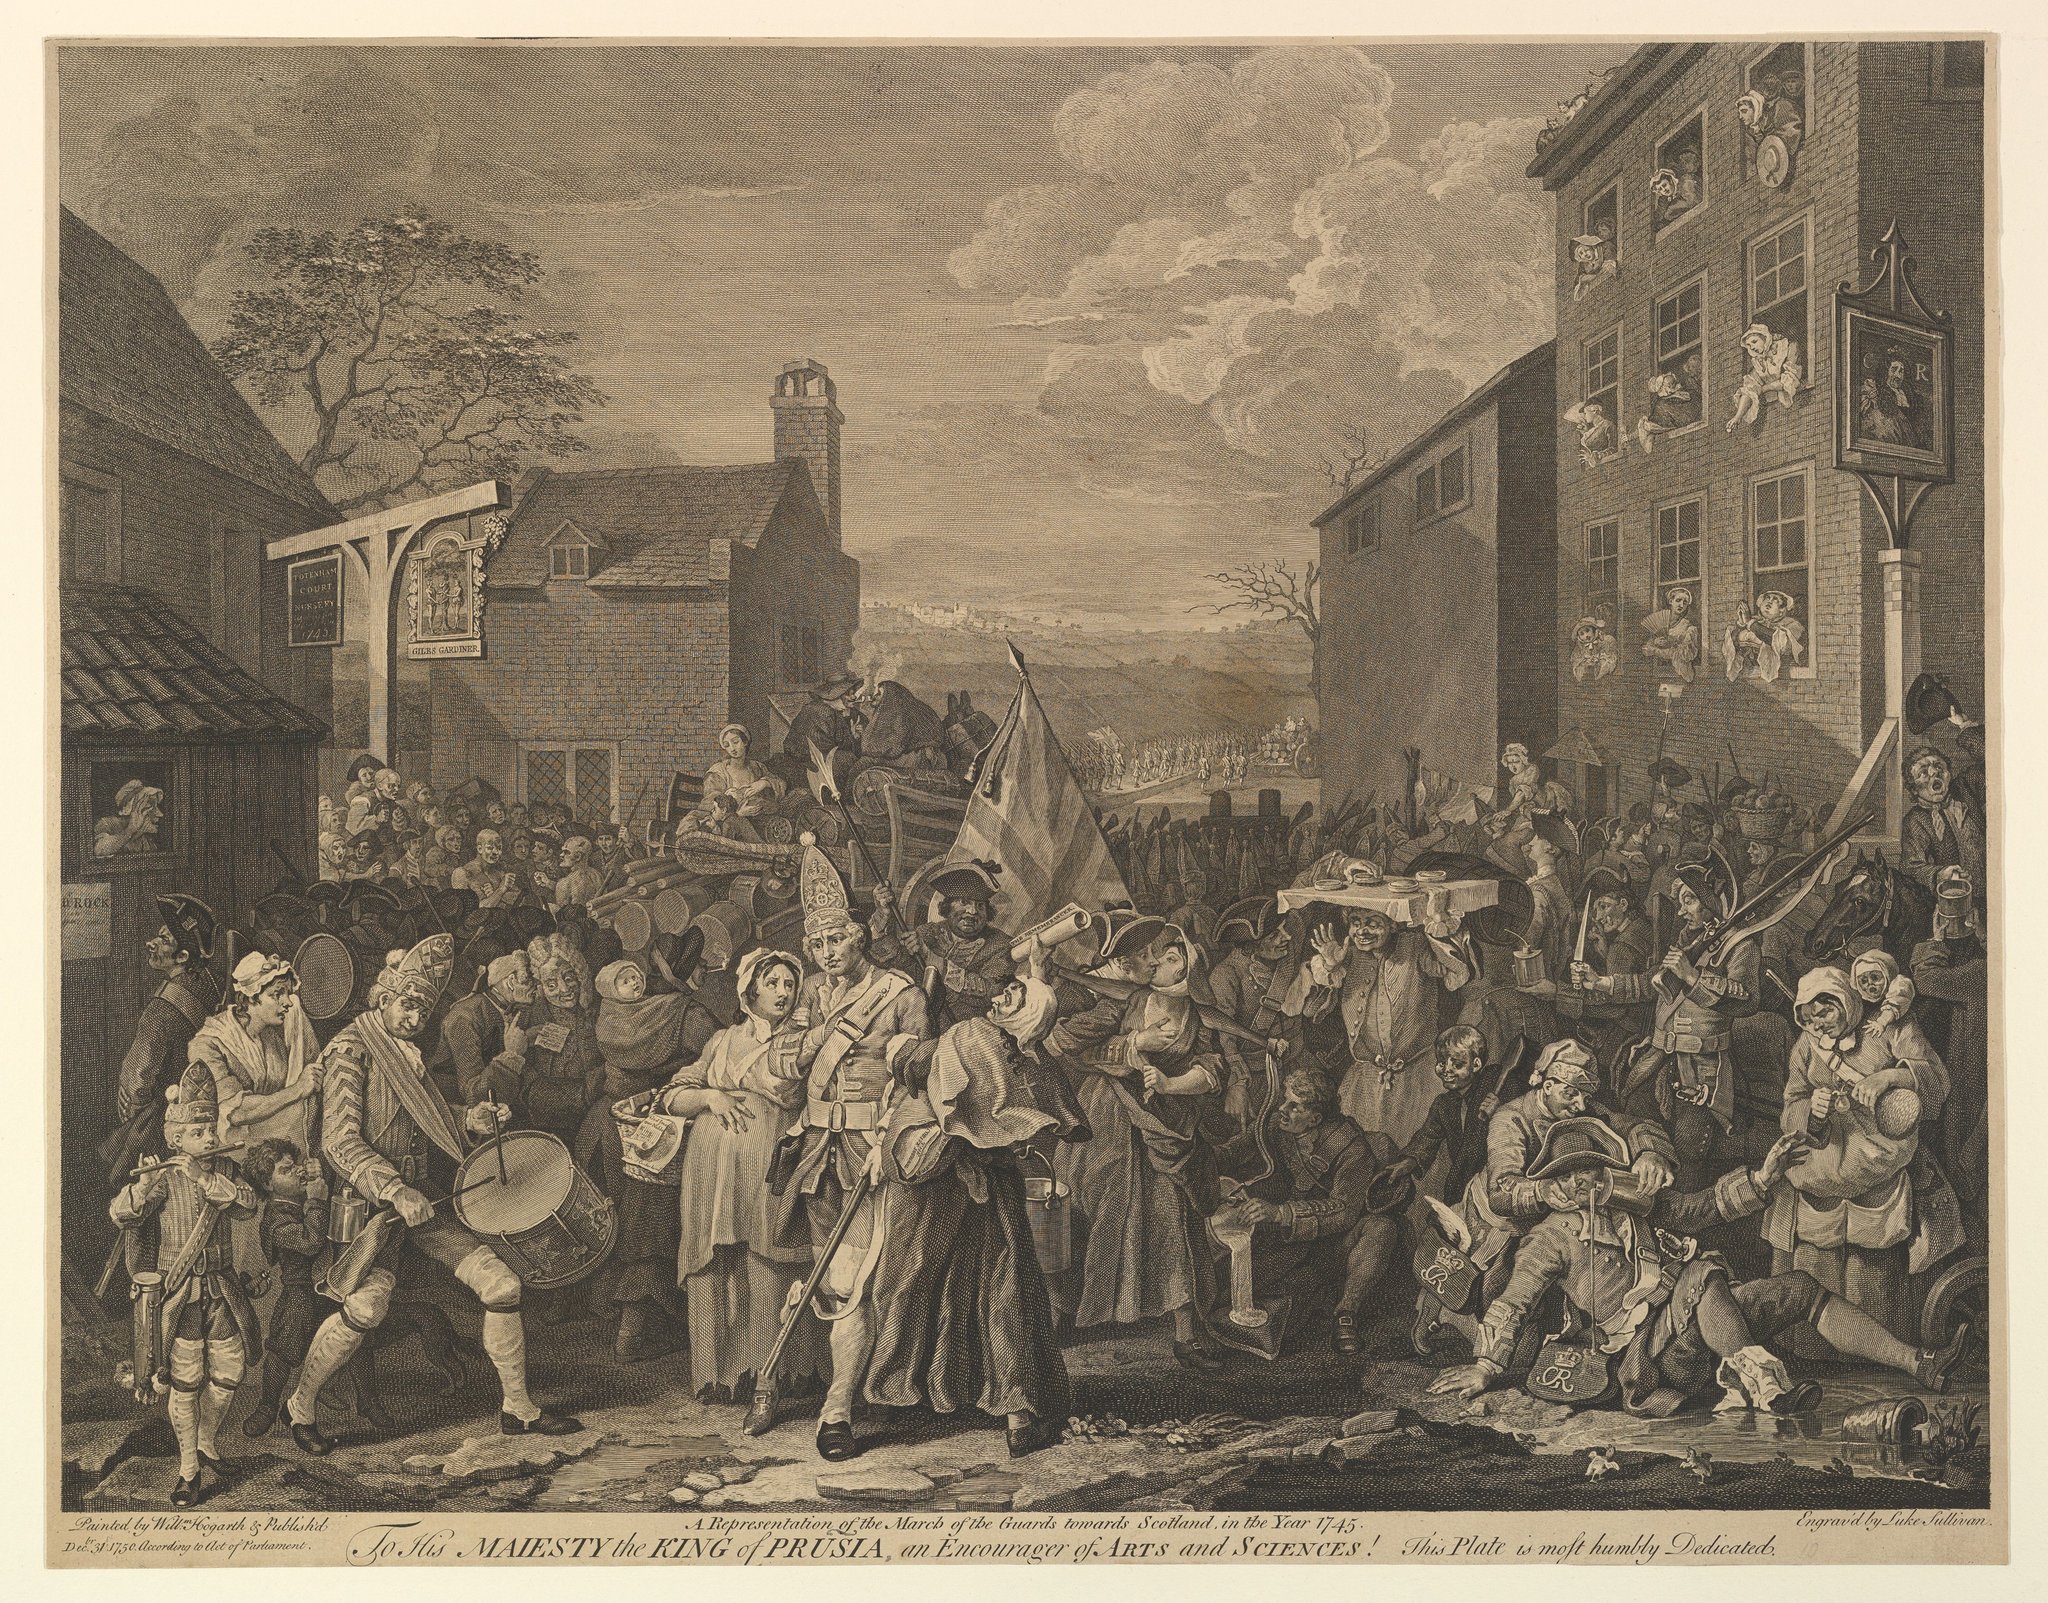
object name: print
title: The March to Finchley (A Representation of the March of the Guards towards Scotland in the Year 1745)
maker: luke sullivan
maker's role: engraver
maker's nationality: irish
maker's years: 1705-1771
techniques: engraving, etching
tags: drums,crowd,flags